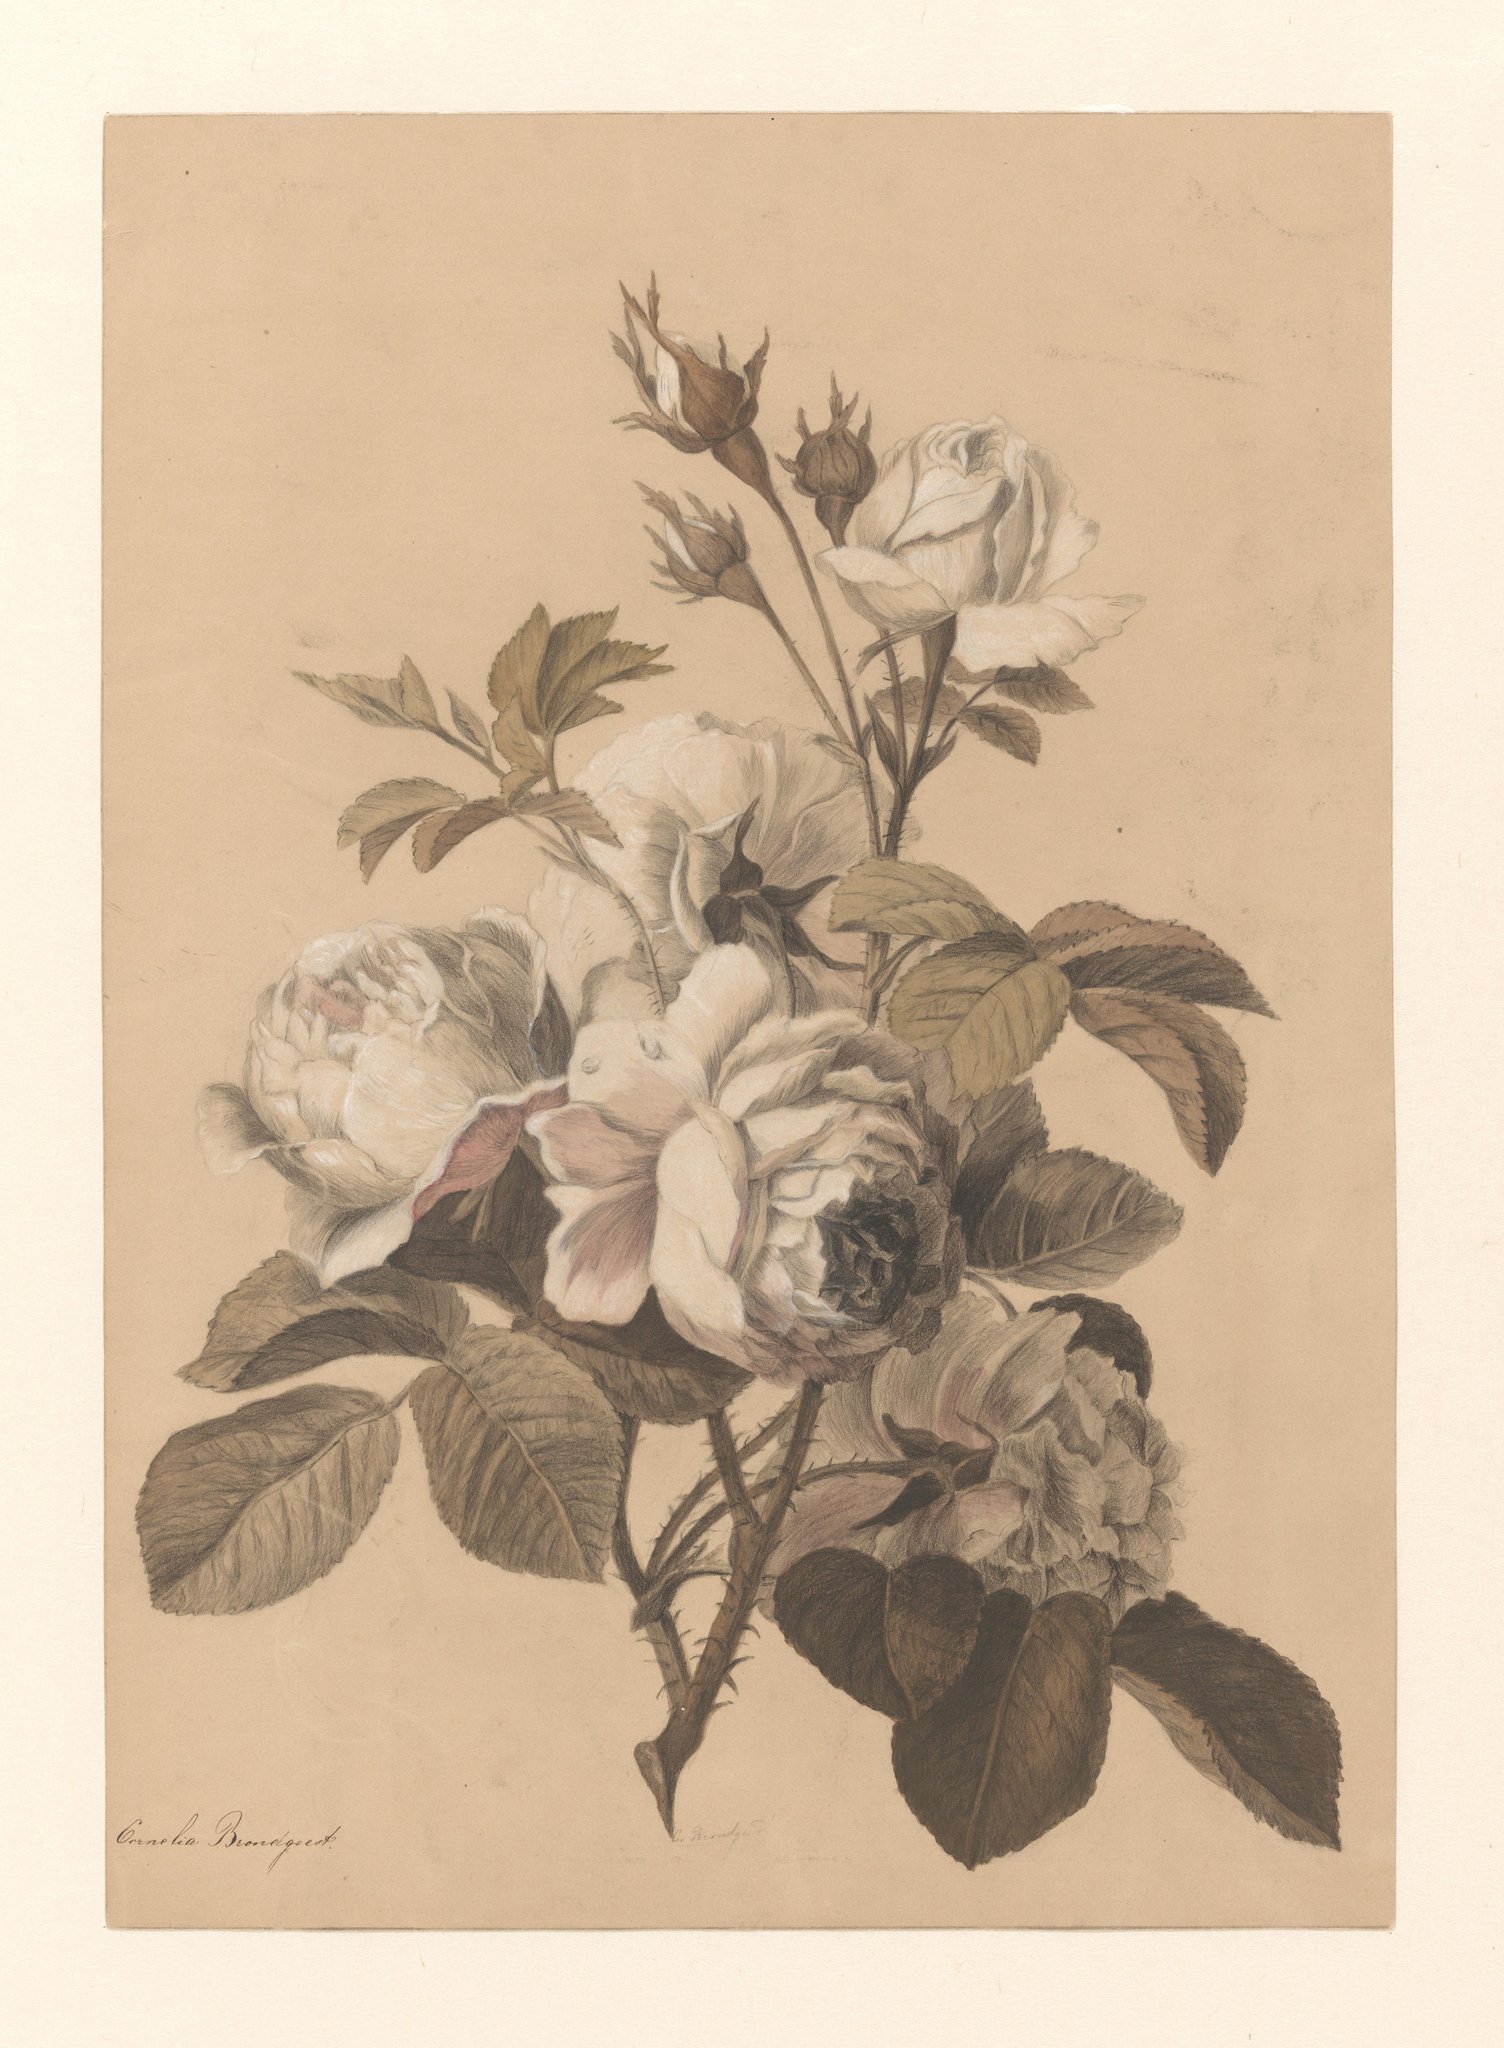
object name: drawing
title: Enkele takken met rozen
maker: cornelia brondgeest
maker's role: draughtsman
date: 1800-1900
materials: chalk, paper, watercolor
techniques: brush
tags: flowers: rose